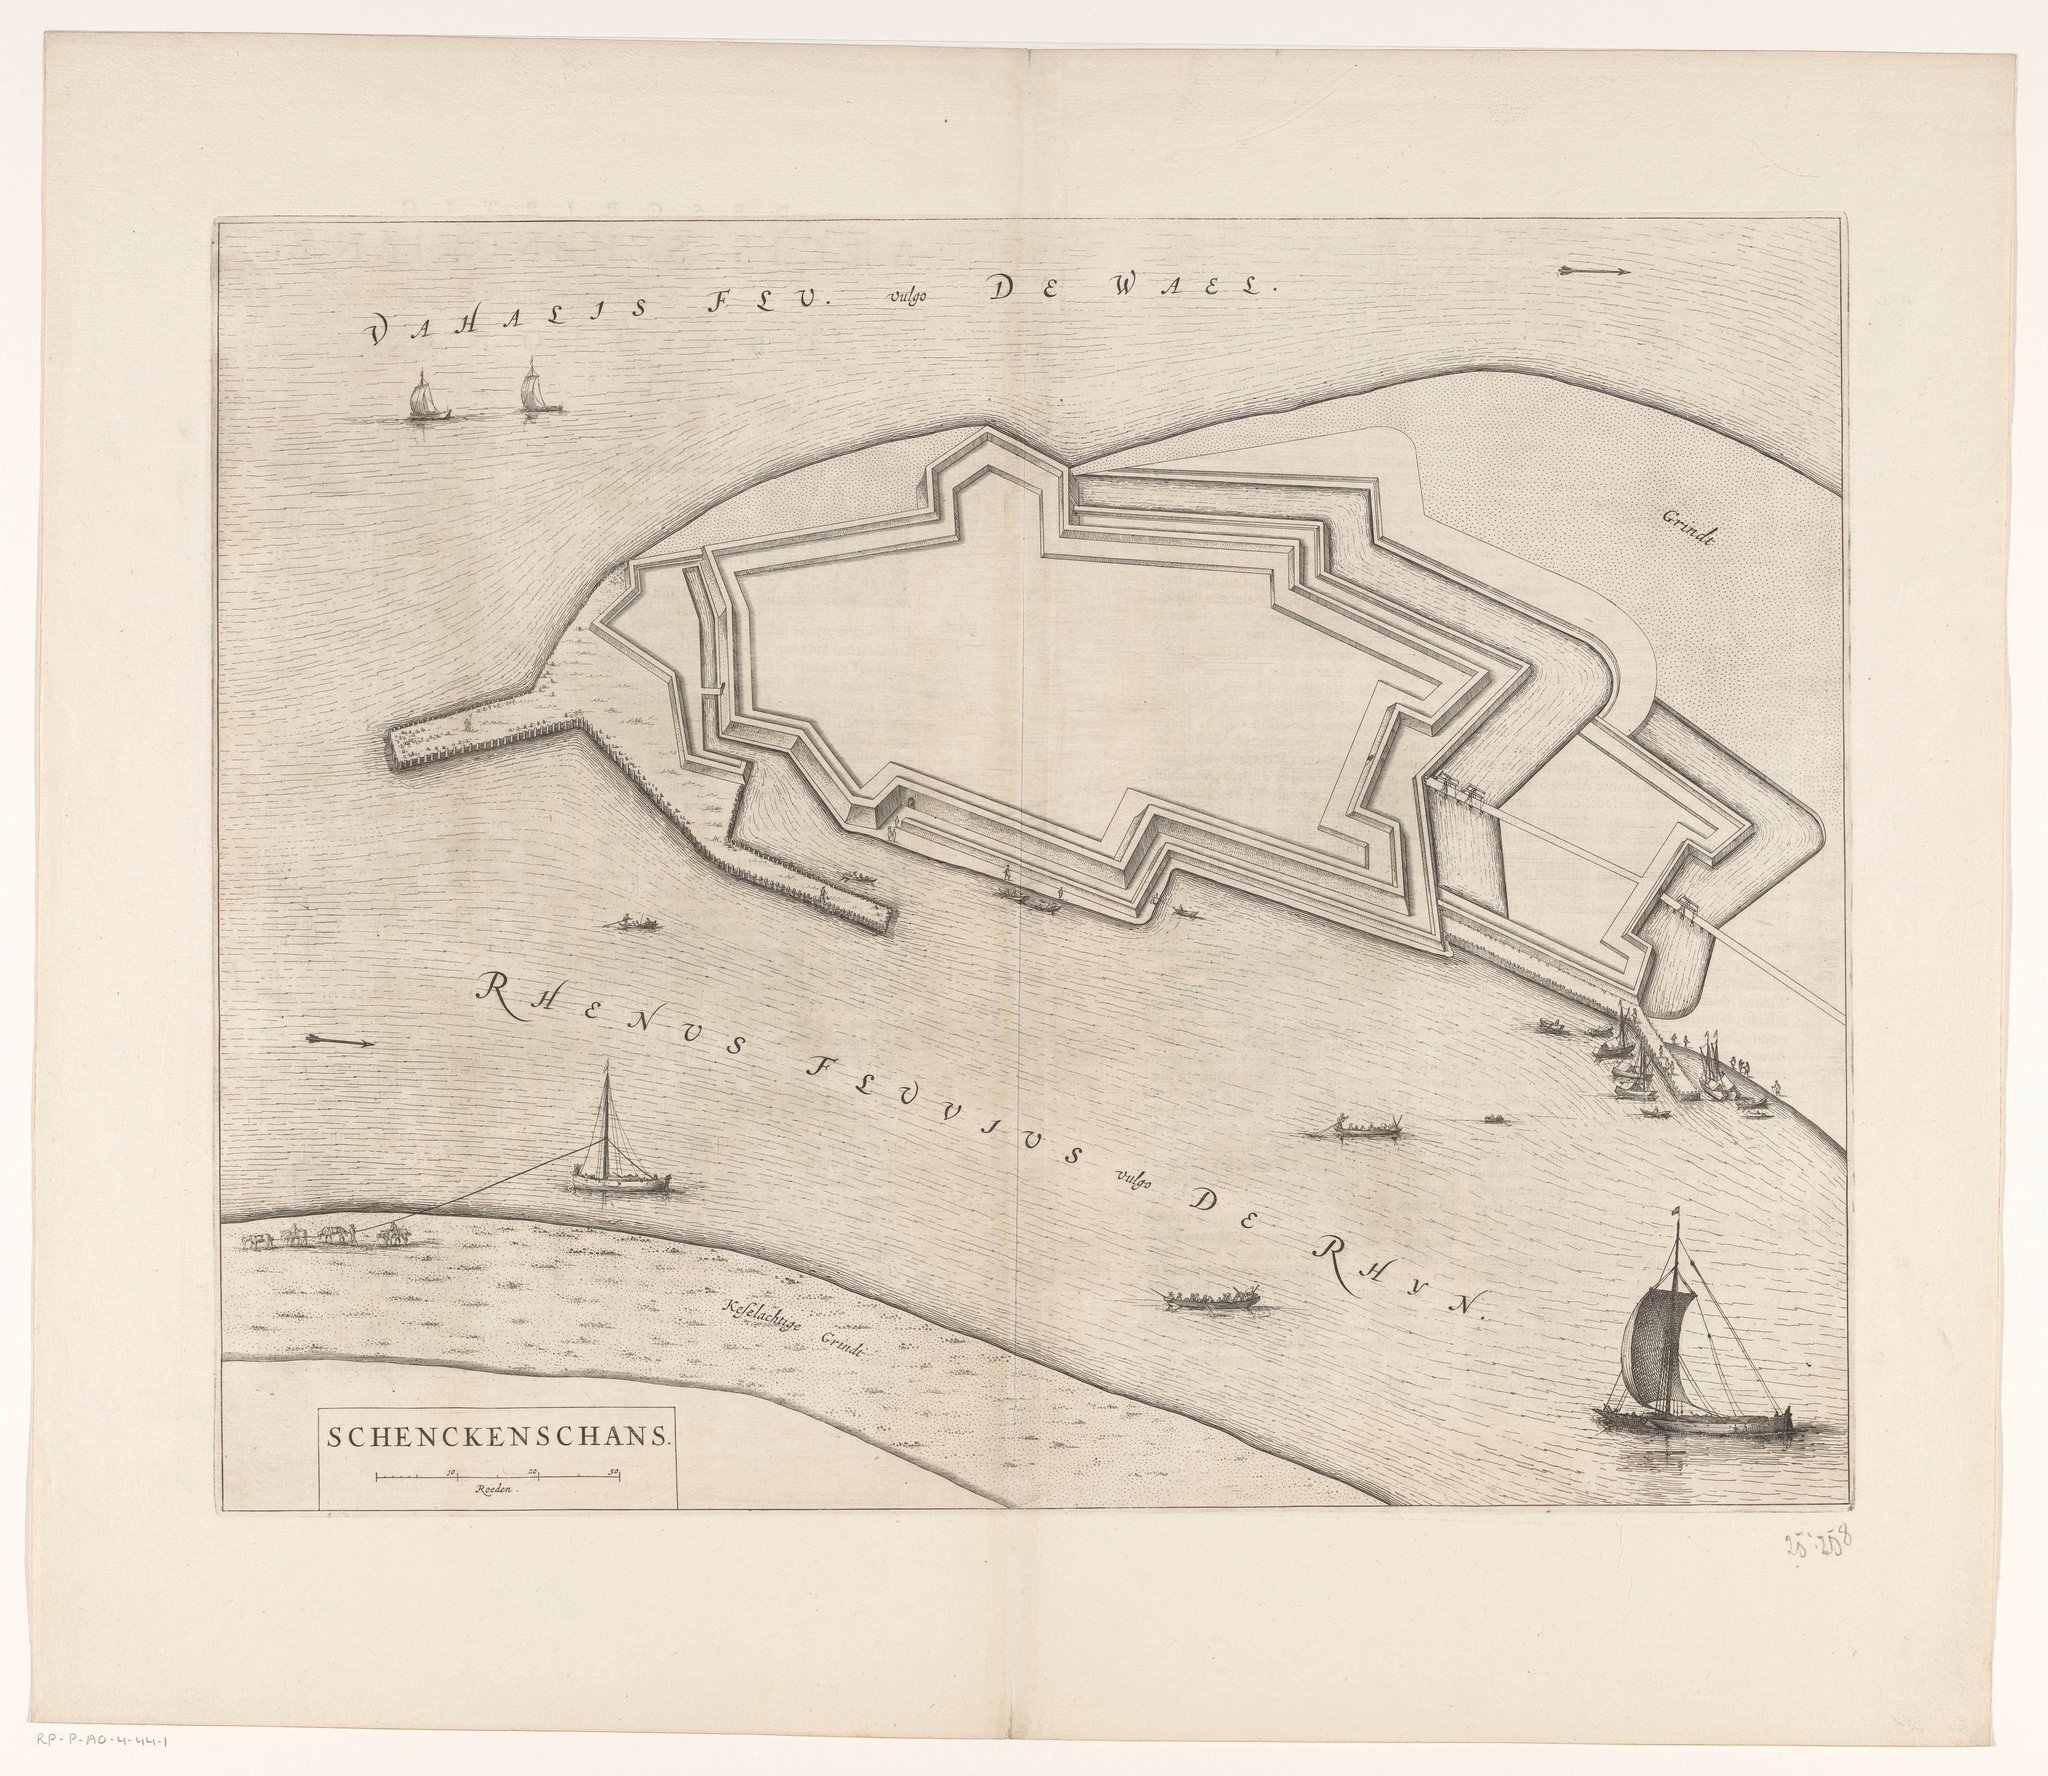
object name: area plan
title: Vestingplattegrond van Schenkenschans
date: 1652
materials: paper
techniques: engraving, etching, letterpress printing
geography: amsterdam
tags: maps of cities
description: Prent gebruikt in: Blaeu, Johannes Willemszoon. Novum ac magnum theatrum urbium Belgicae (...). 2 delen. 3e druk. Amsterdam: Johannes Willemszoon Blaeu, 1652, dl. 1.